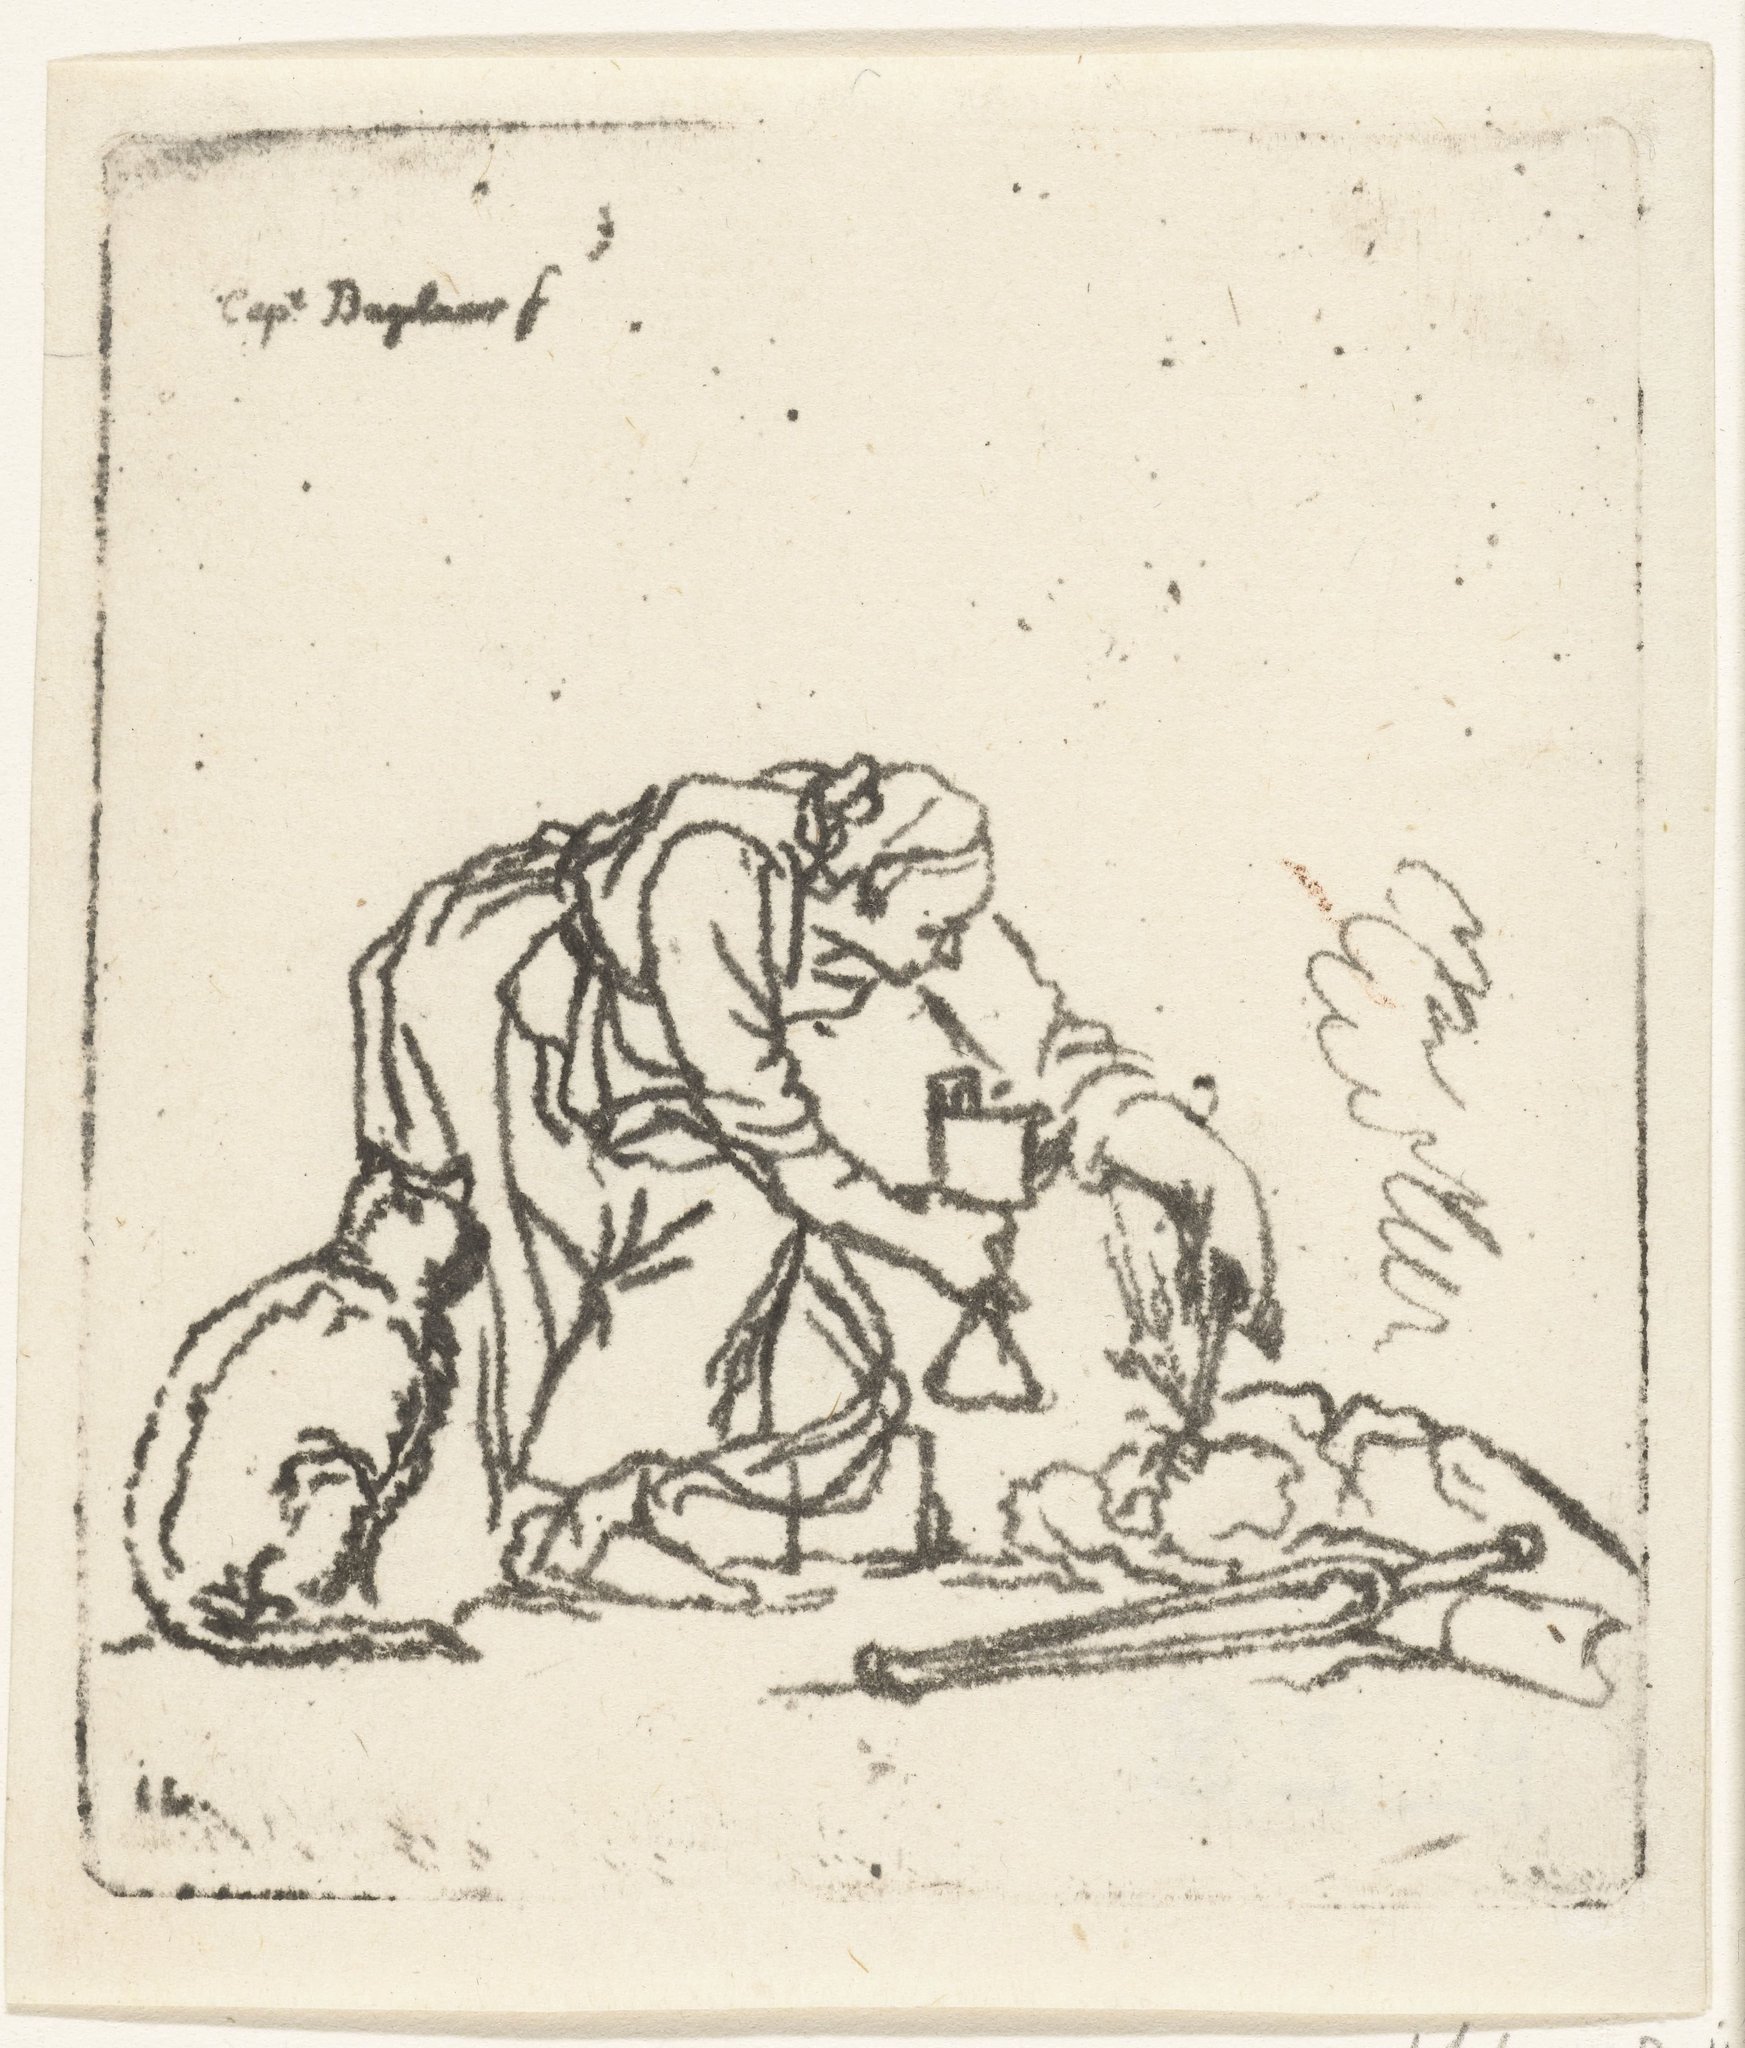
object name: print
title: Vrouw met zwavelstok en lamp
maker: ernst willem jan bagelaar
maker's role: draughtsman, print maker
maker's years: 1775-1837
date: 1798-1837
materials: paper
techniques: etching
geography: netherlands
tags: witch, sorceress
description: Een vrouw staat voorovergebogen, in haar ene hand een lamp, in de andere een zwavelstokje. Naast haar zit een poes.